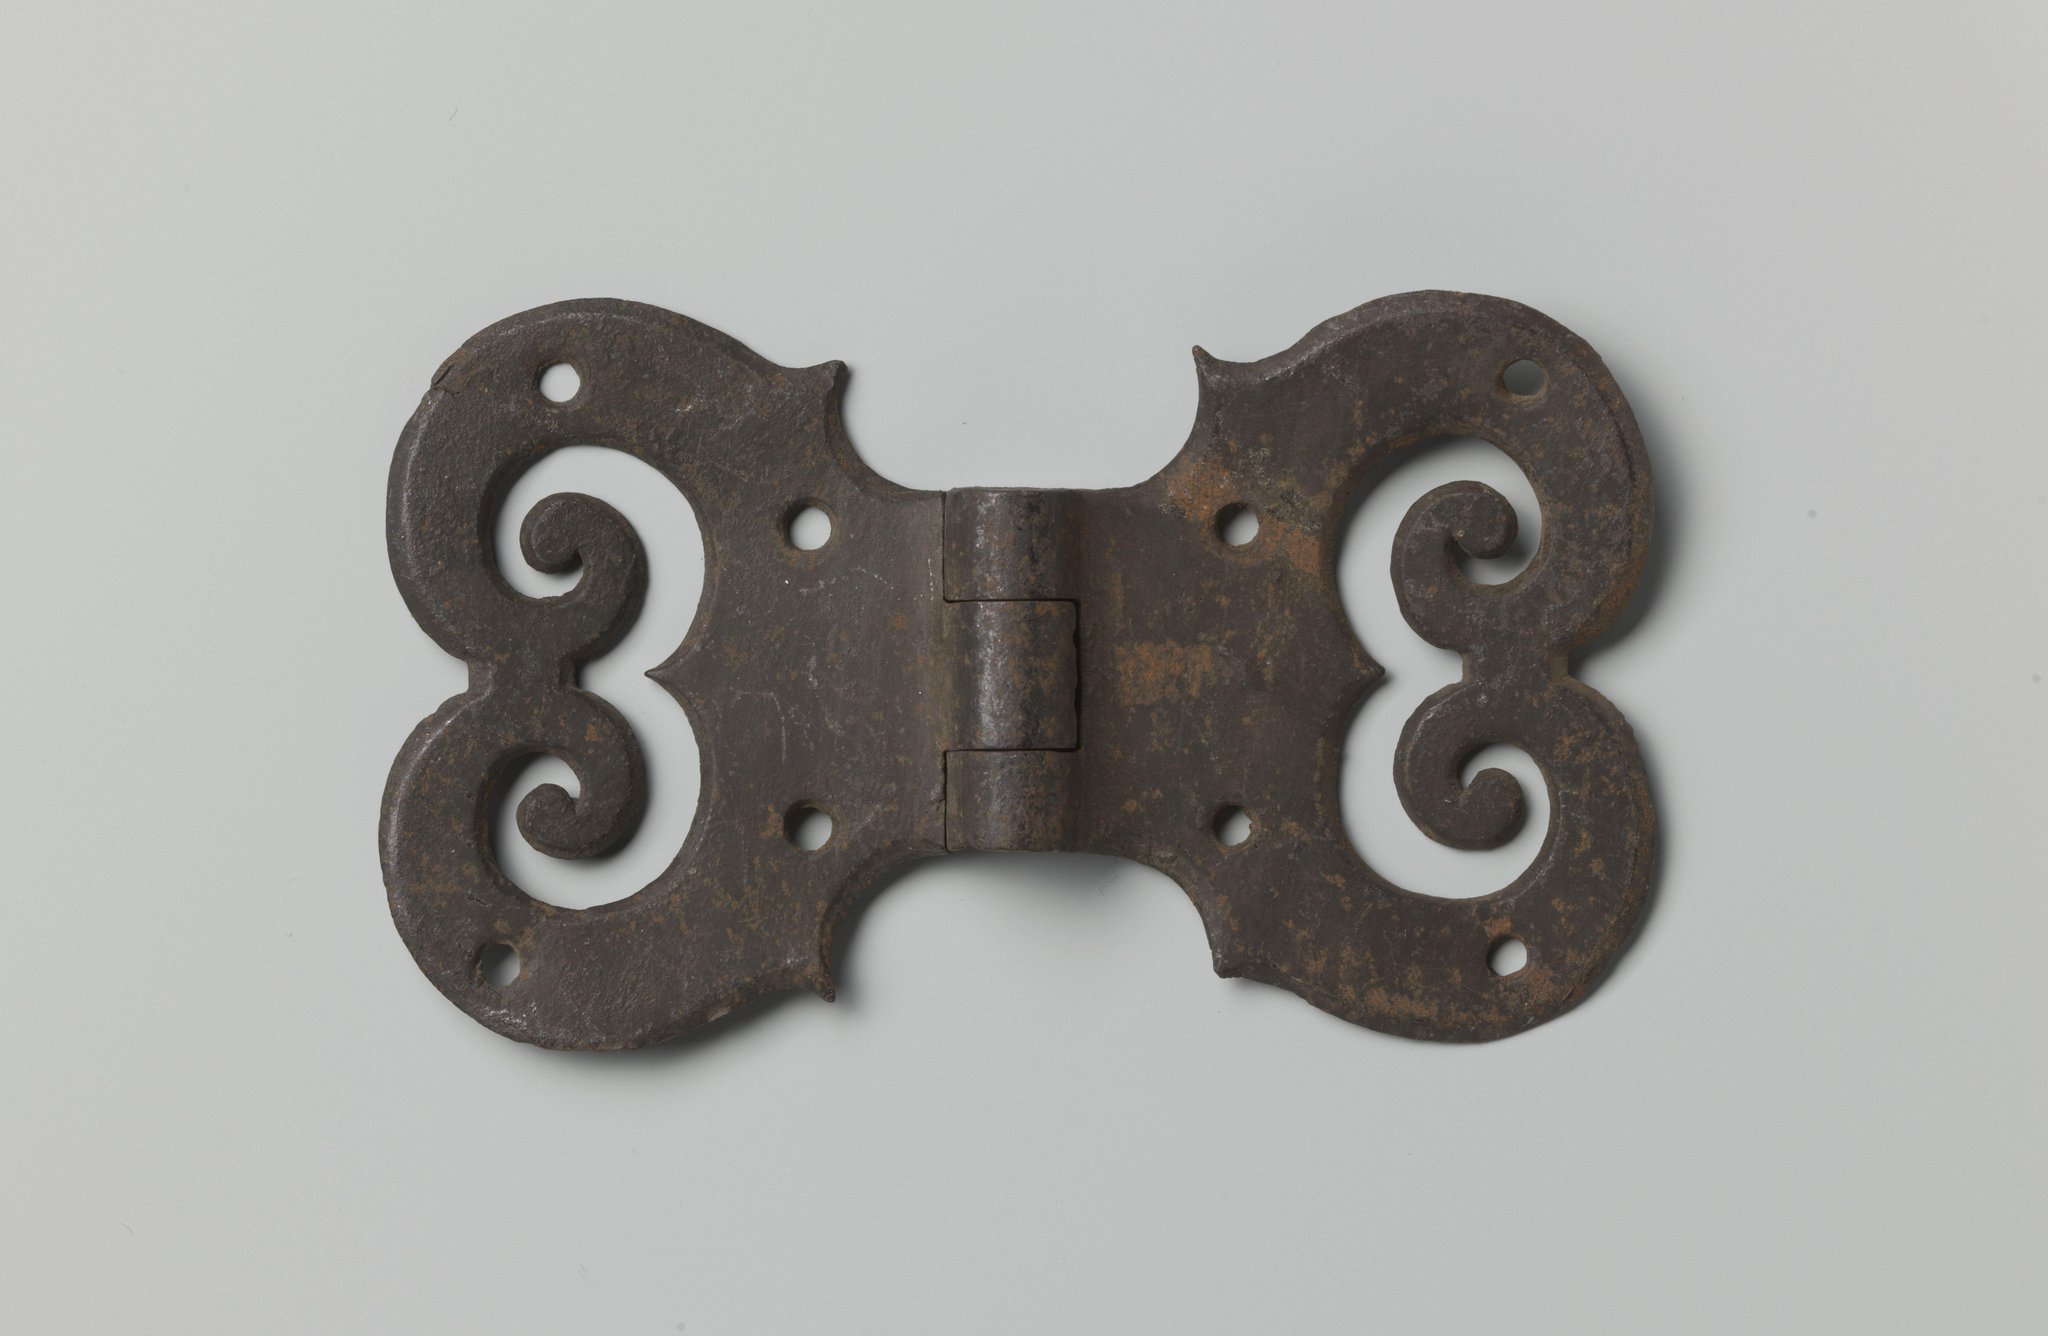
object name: scharnier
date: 1400-1950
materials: iron